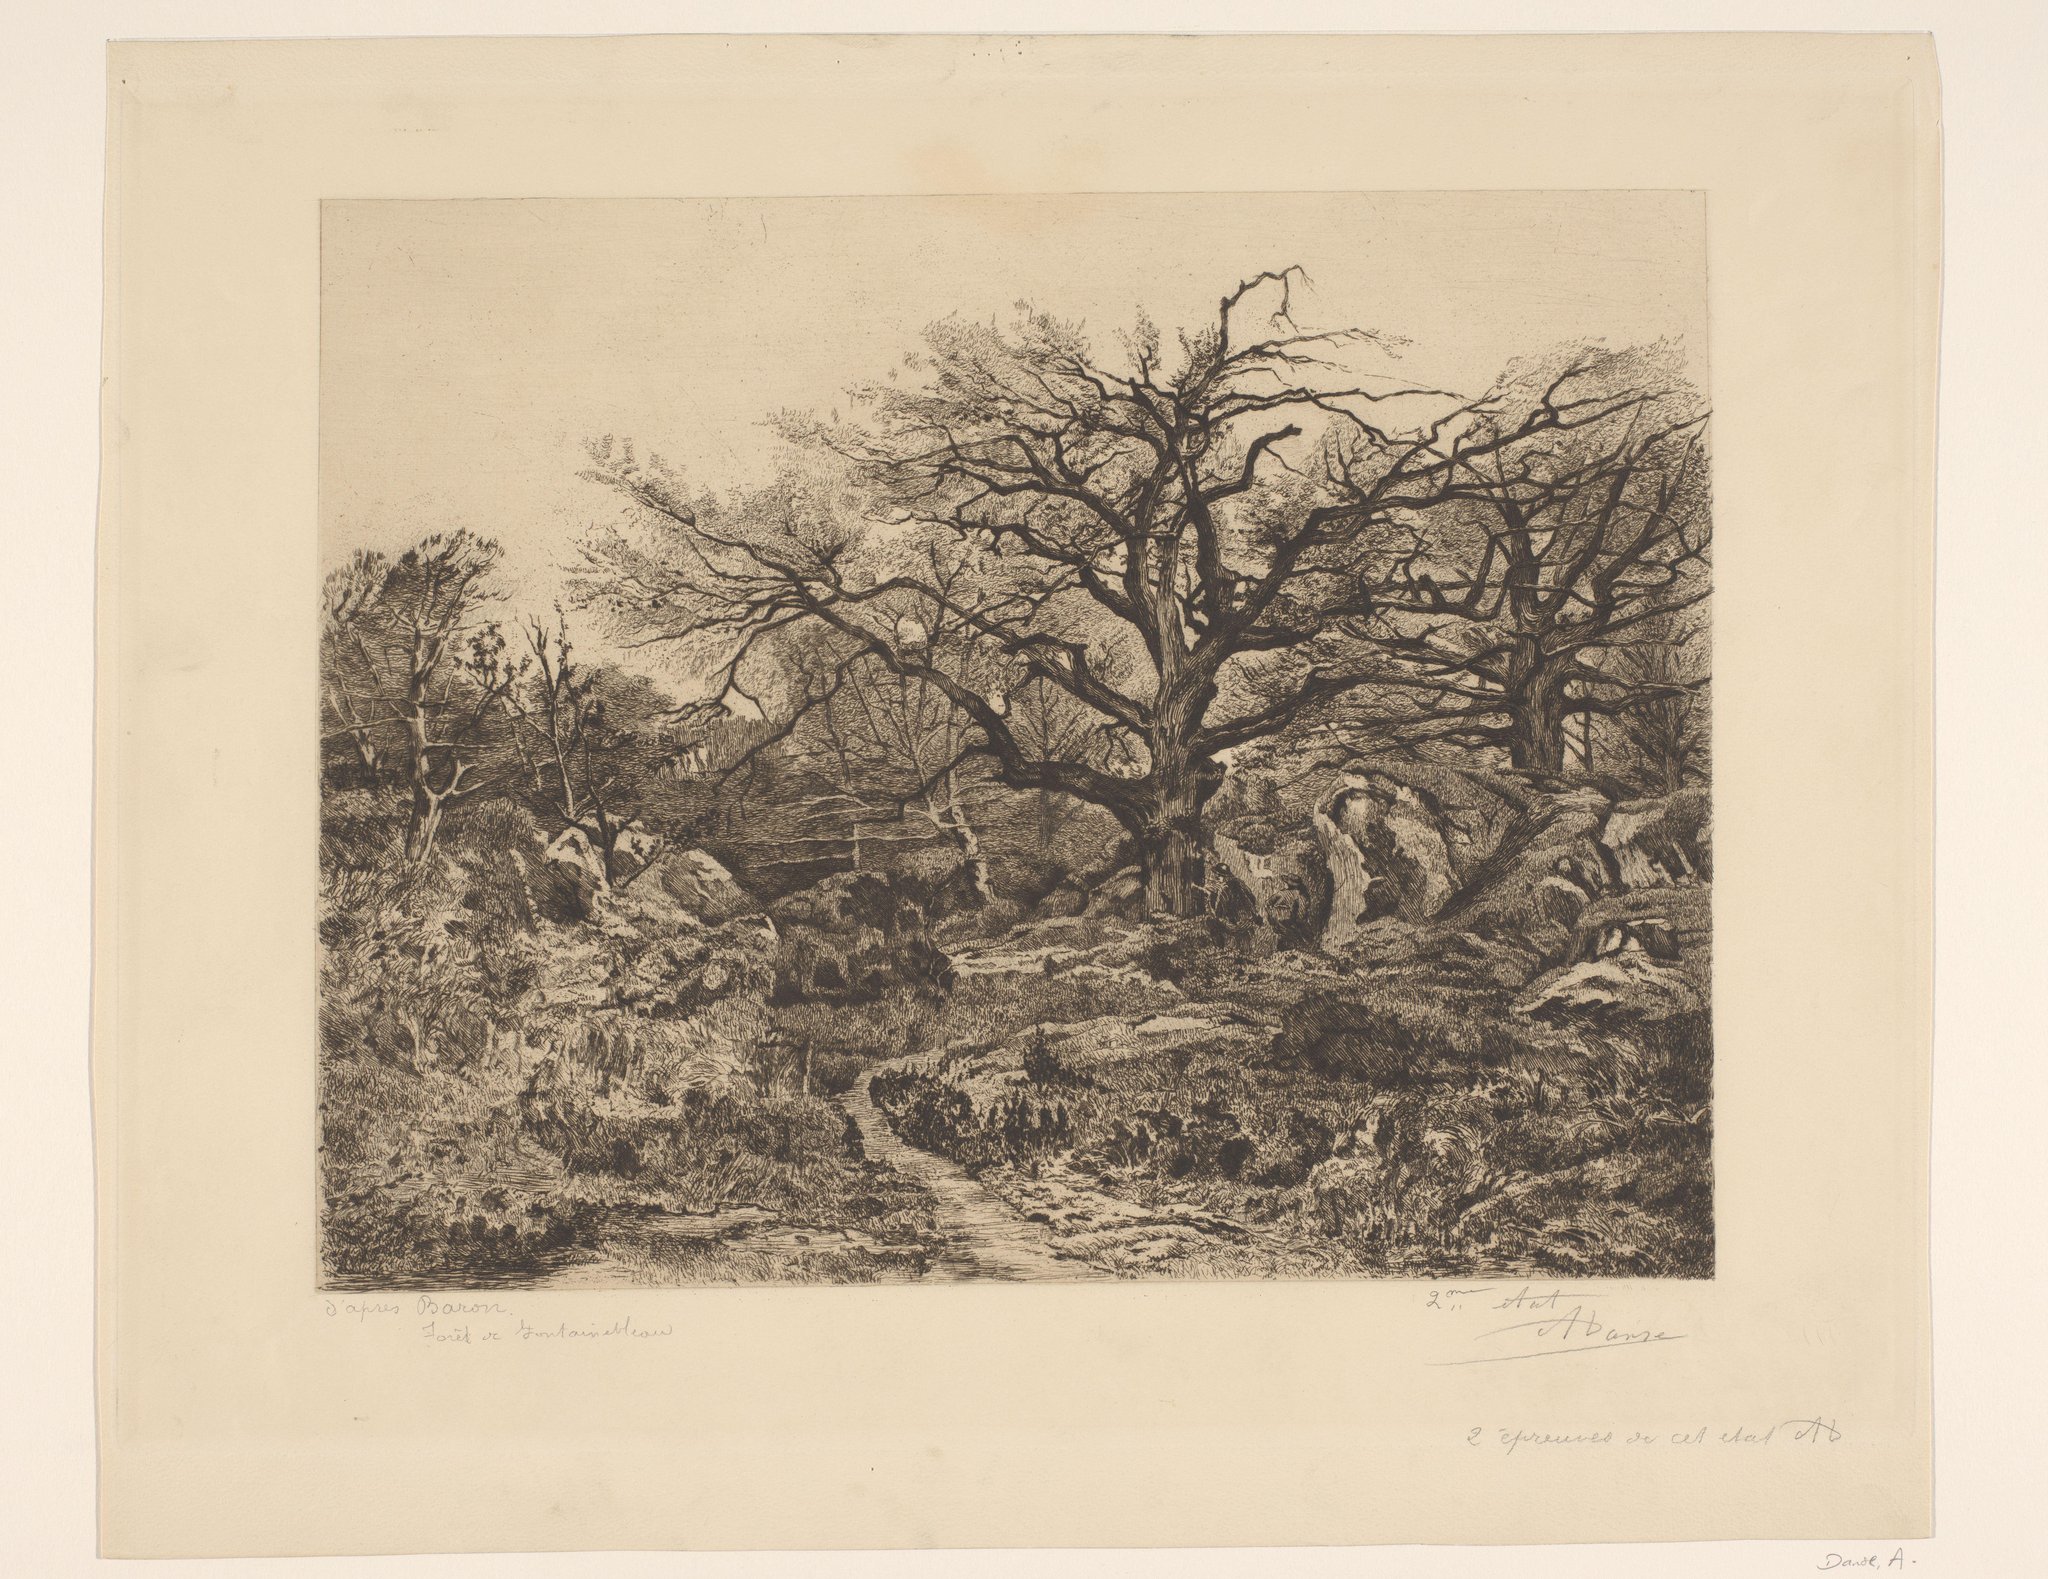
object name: print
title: Jagers in het bos van Fontainebleau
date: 1897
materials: paper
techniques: drypoint, etching, intaglio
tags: hunters hunting (n.b.: in 1988-1990 this notation denoted the concept of 43c11421 'hunters resting during the hunt')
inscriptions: collector's mark: Lugt 2228, annotation: ‘2me etat; 2 épreuves de cet etat’